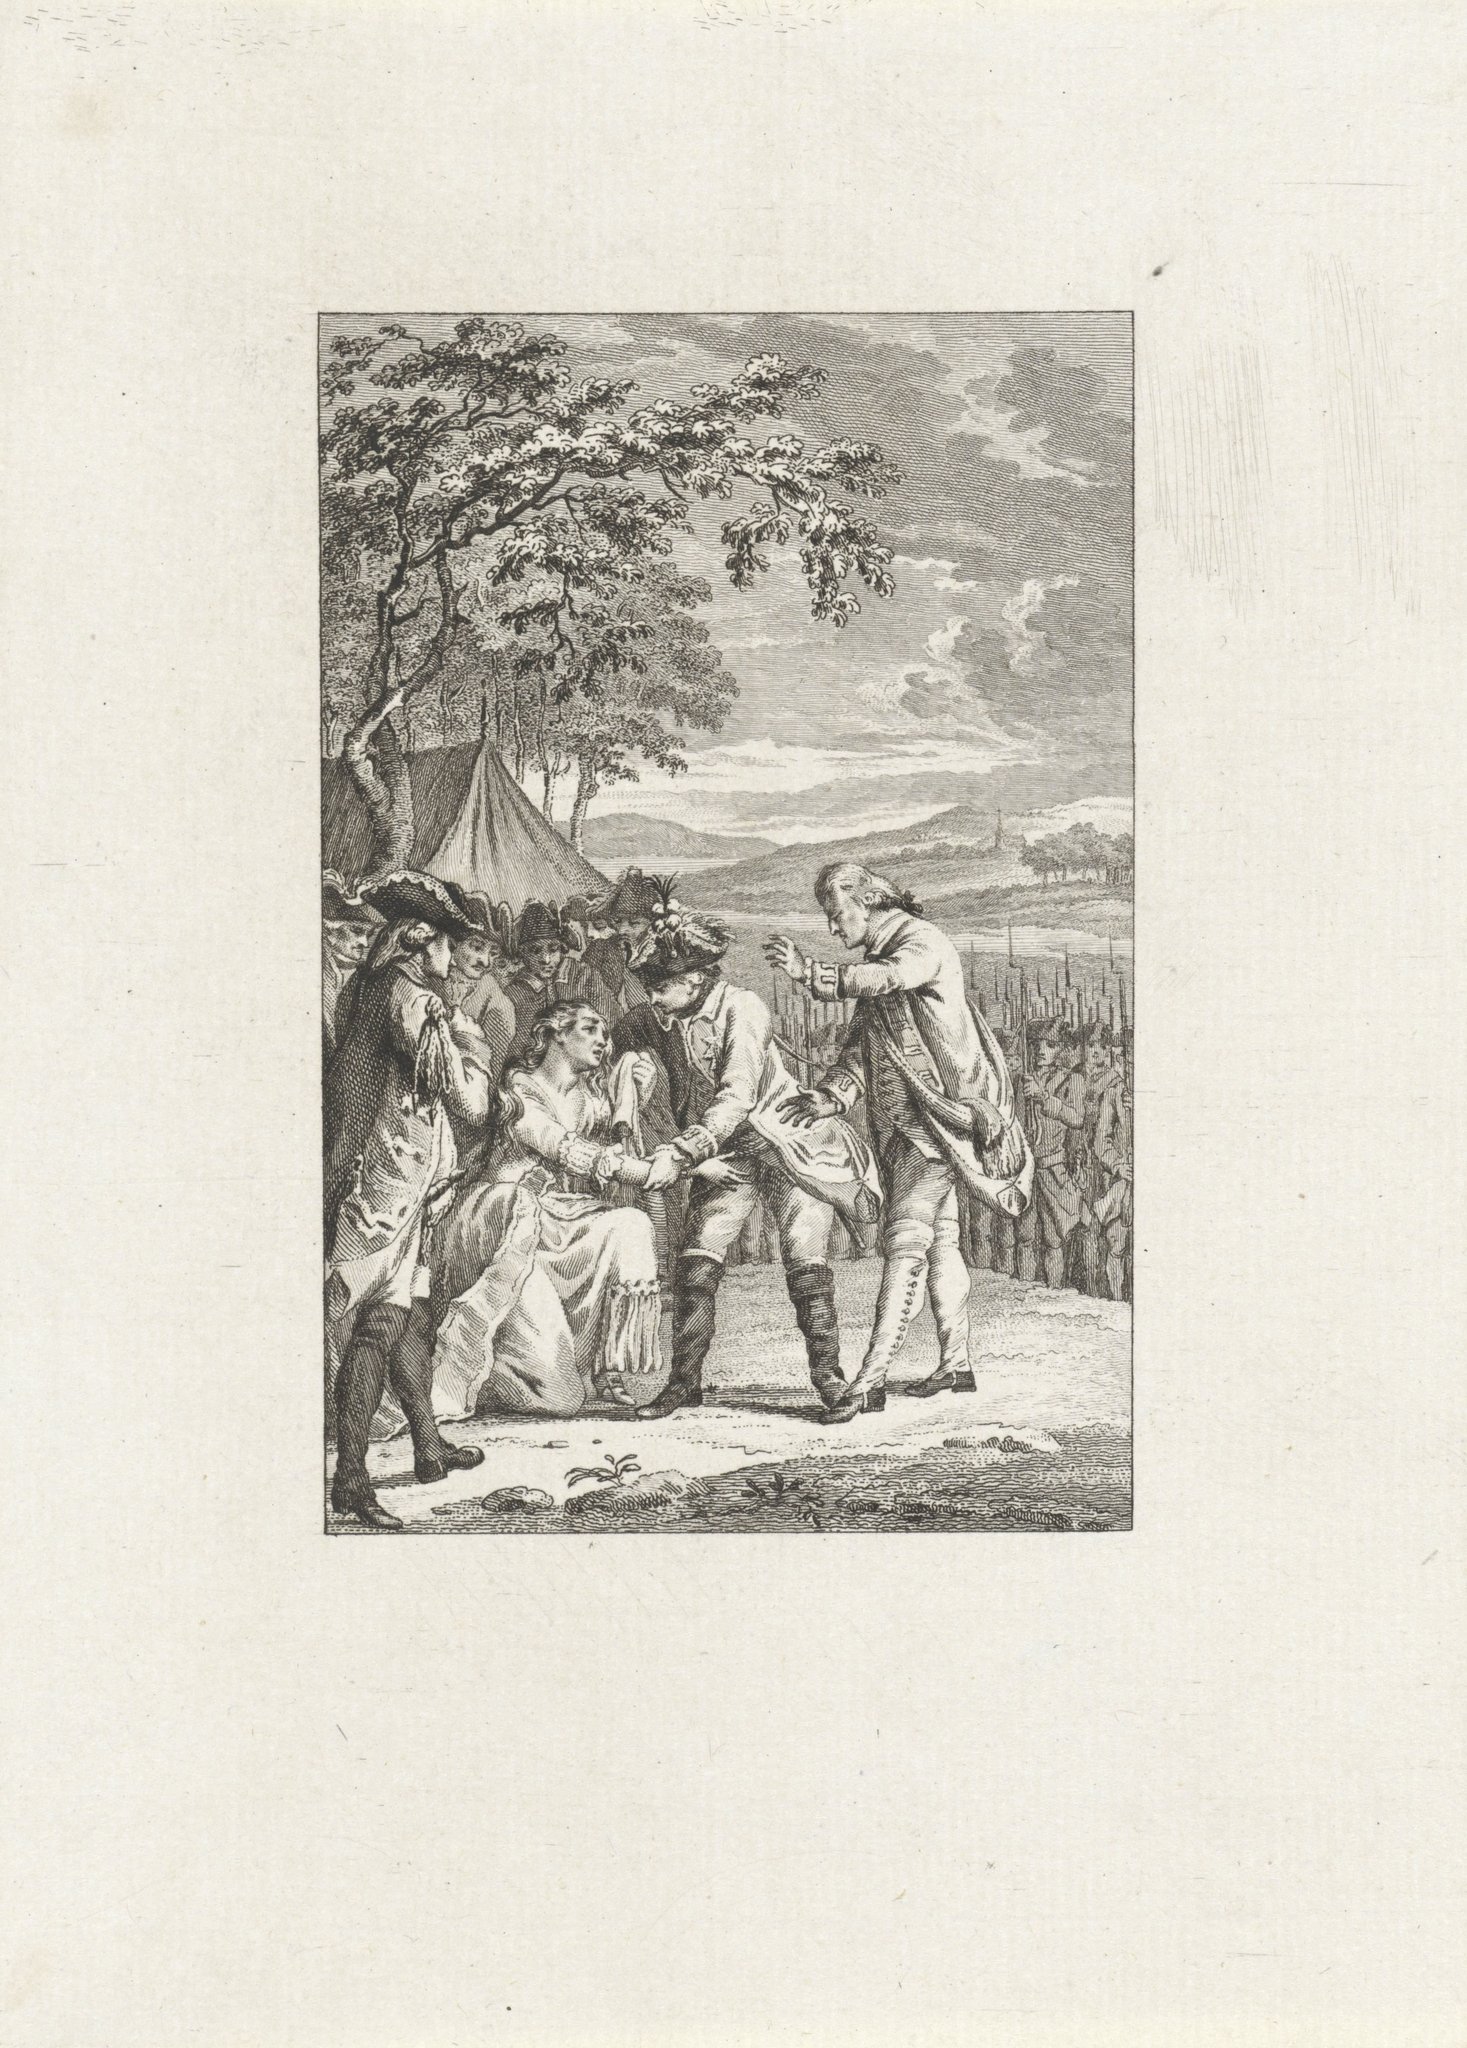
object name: print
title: Huilende vrouw in een legerkamp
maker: reinier vinkeles (i)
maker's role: draughtsman, print maker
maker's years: 1741-1816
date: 1781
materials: paper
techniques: engraving, etching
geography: amsterdam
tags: (military) camp with tents, weeping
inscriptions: collector's mark: Lugt 240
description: Proefdruk van een prent die ook gebruikt is als illustratie in: Spectatoriaale schouwburg, behelzende eene verzameling der beste zedelyke tooneelstukken, byeen gebragt uit alle (...) taalen van Europa. Deel 10. Amsterdam: Pieter Meĳer en Gerrit Warnars, 1781, p. 213.